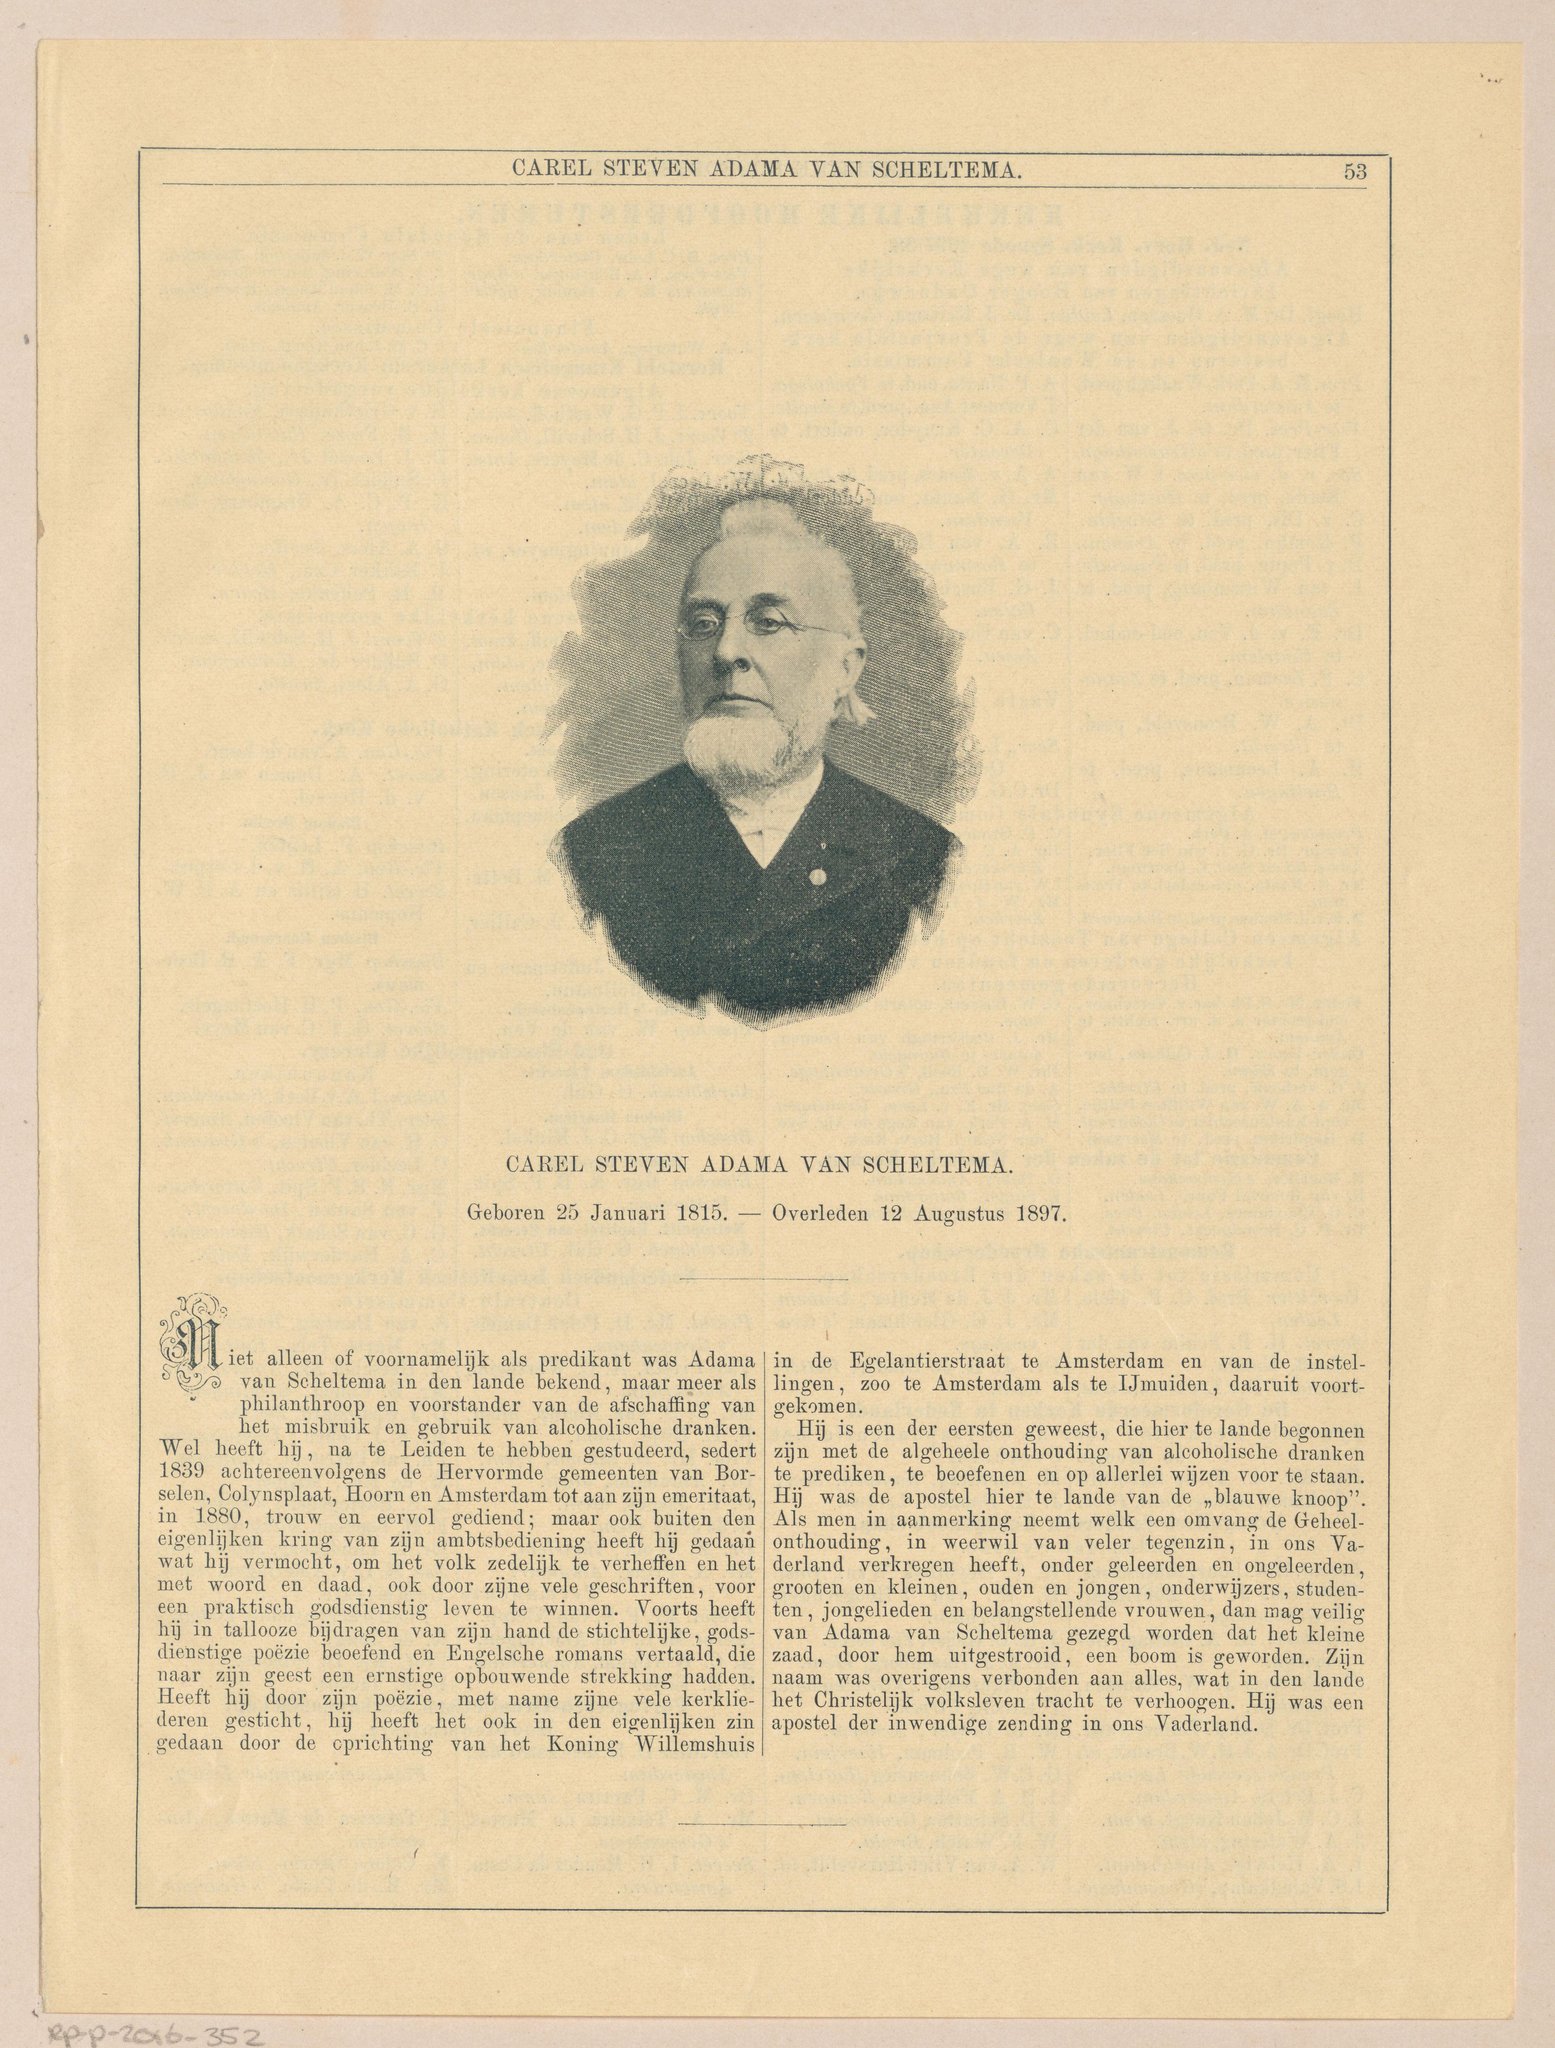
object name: book illustration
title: Portret van Carel Steven Adama van Scheltema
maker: Anonymous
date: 1897-1949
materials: paper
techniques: letterpress printing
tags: the hague, arnhem, carel steven i adama van scheltema, portrait of a writer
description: Portret van Carel Steven Adama van Scheltema. In de ondermarge zijn naam, zijn geboortedatum en zijn sterfdatum in boekdruk.